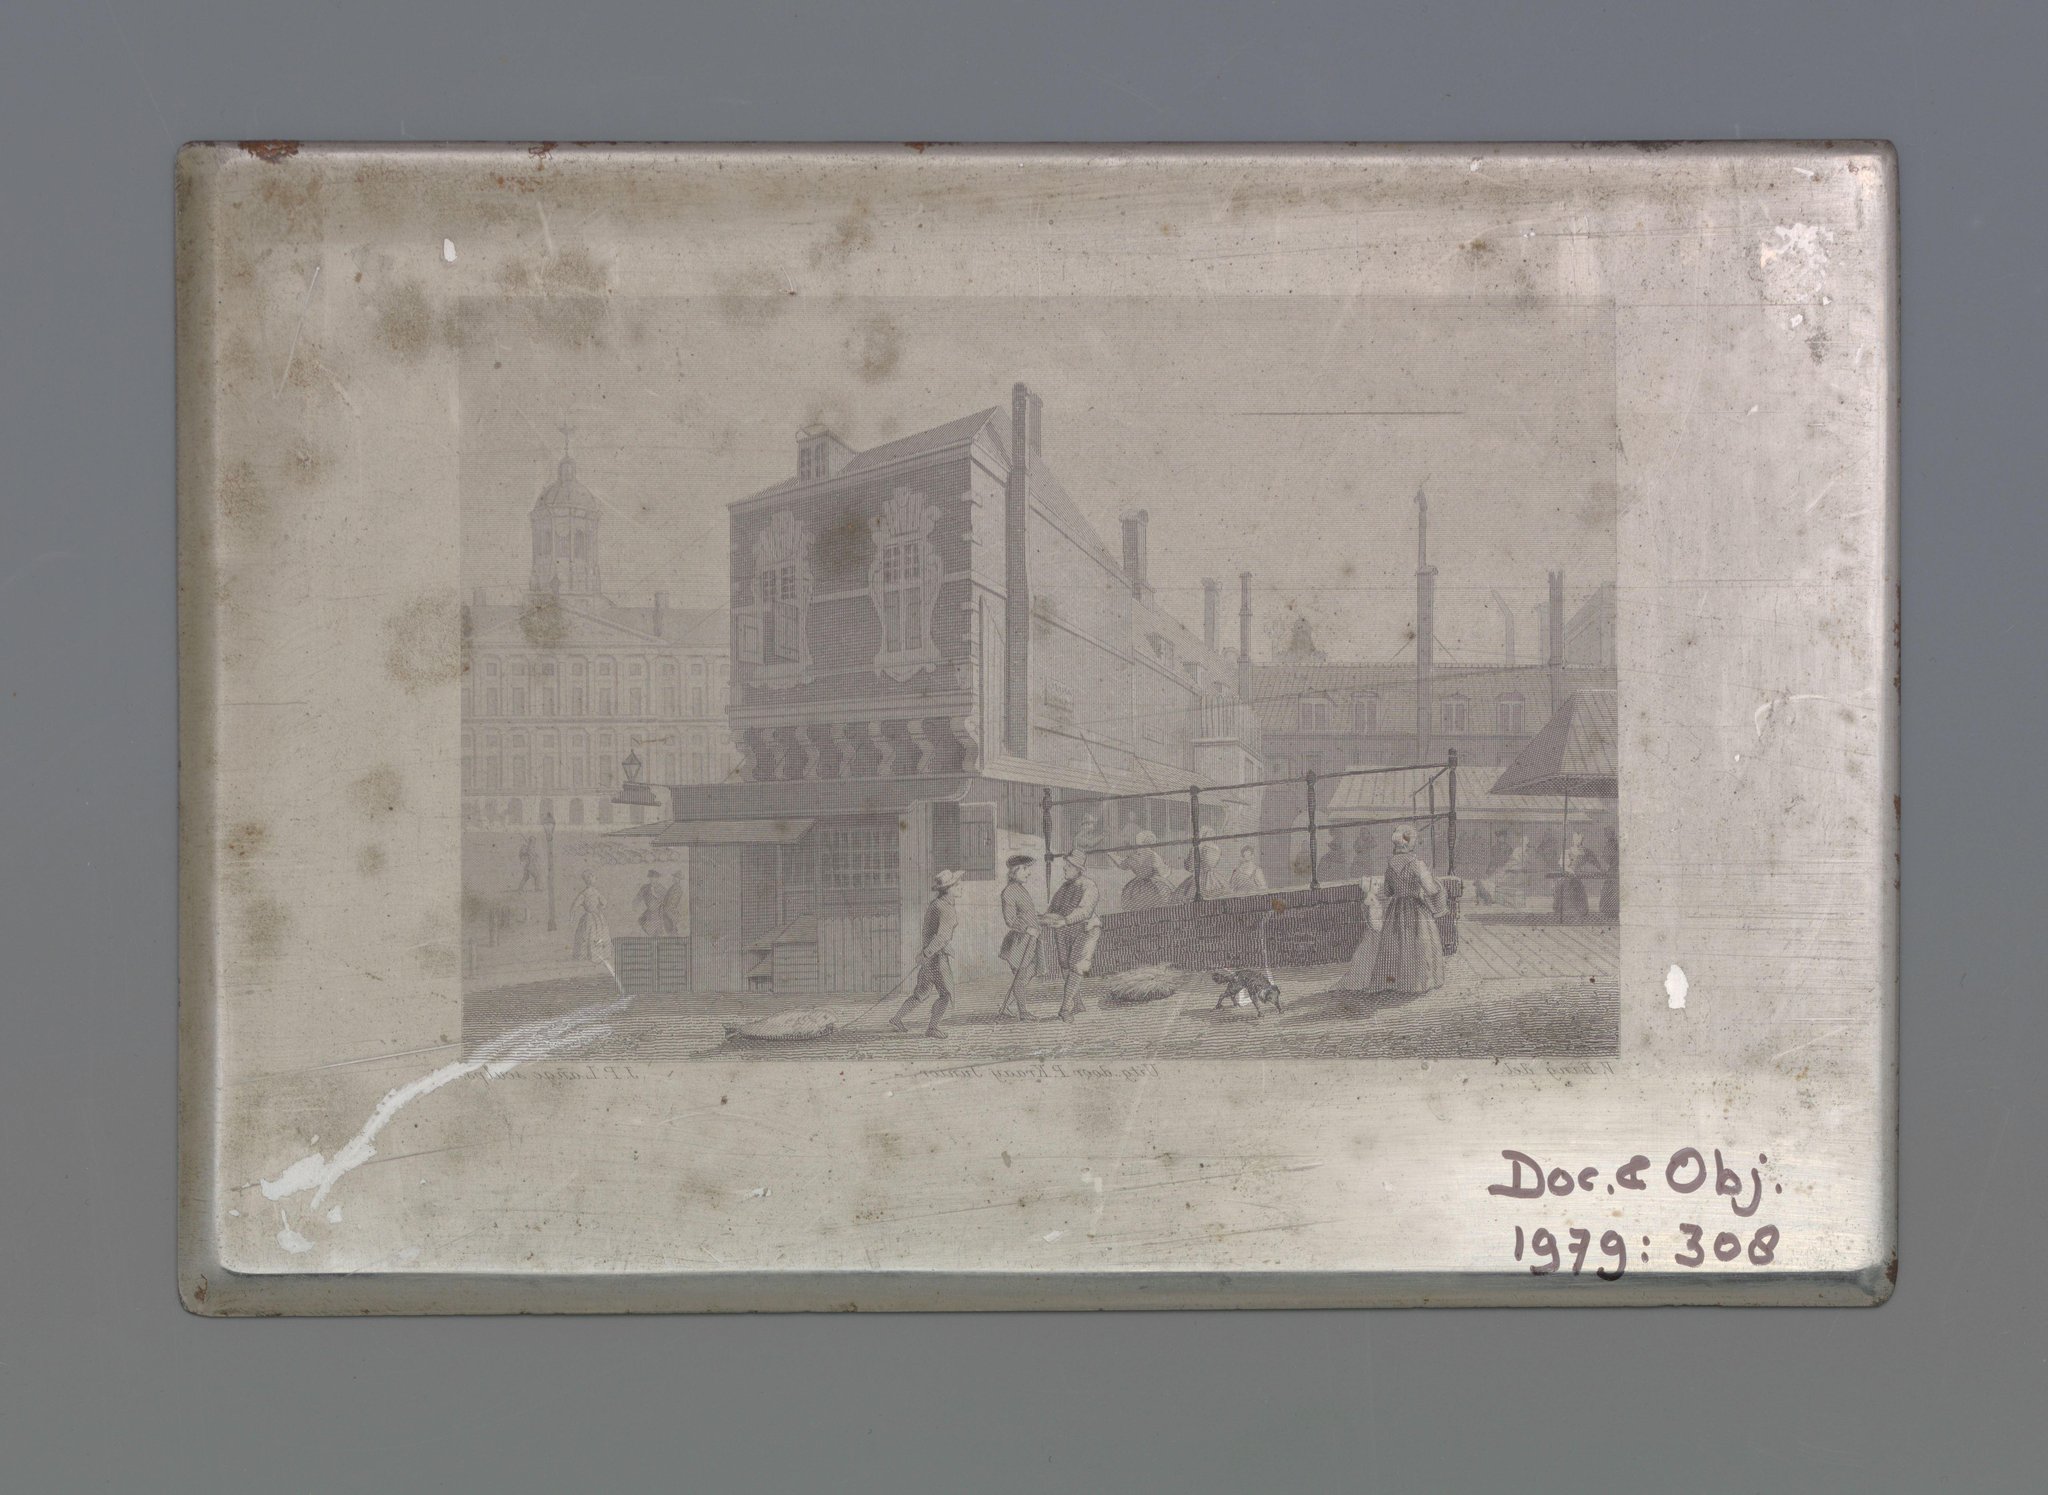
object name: staalplaat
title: Gezicht op de Vismarkt te Amsterdam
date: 1822-1849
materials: steel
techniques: engraving